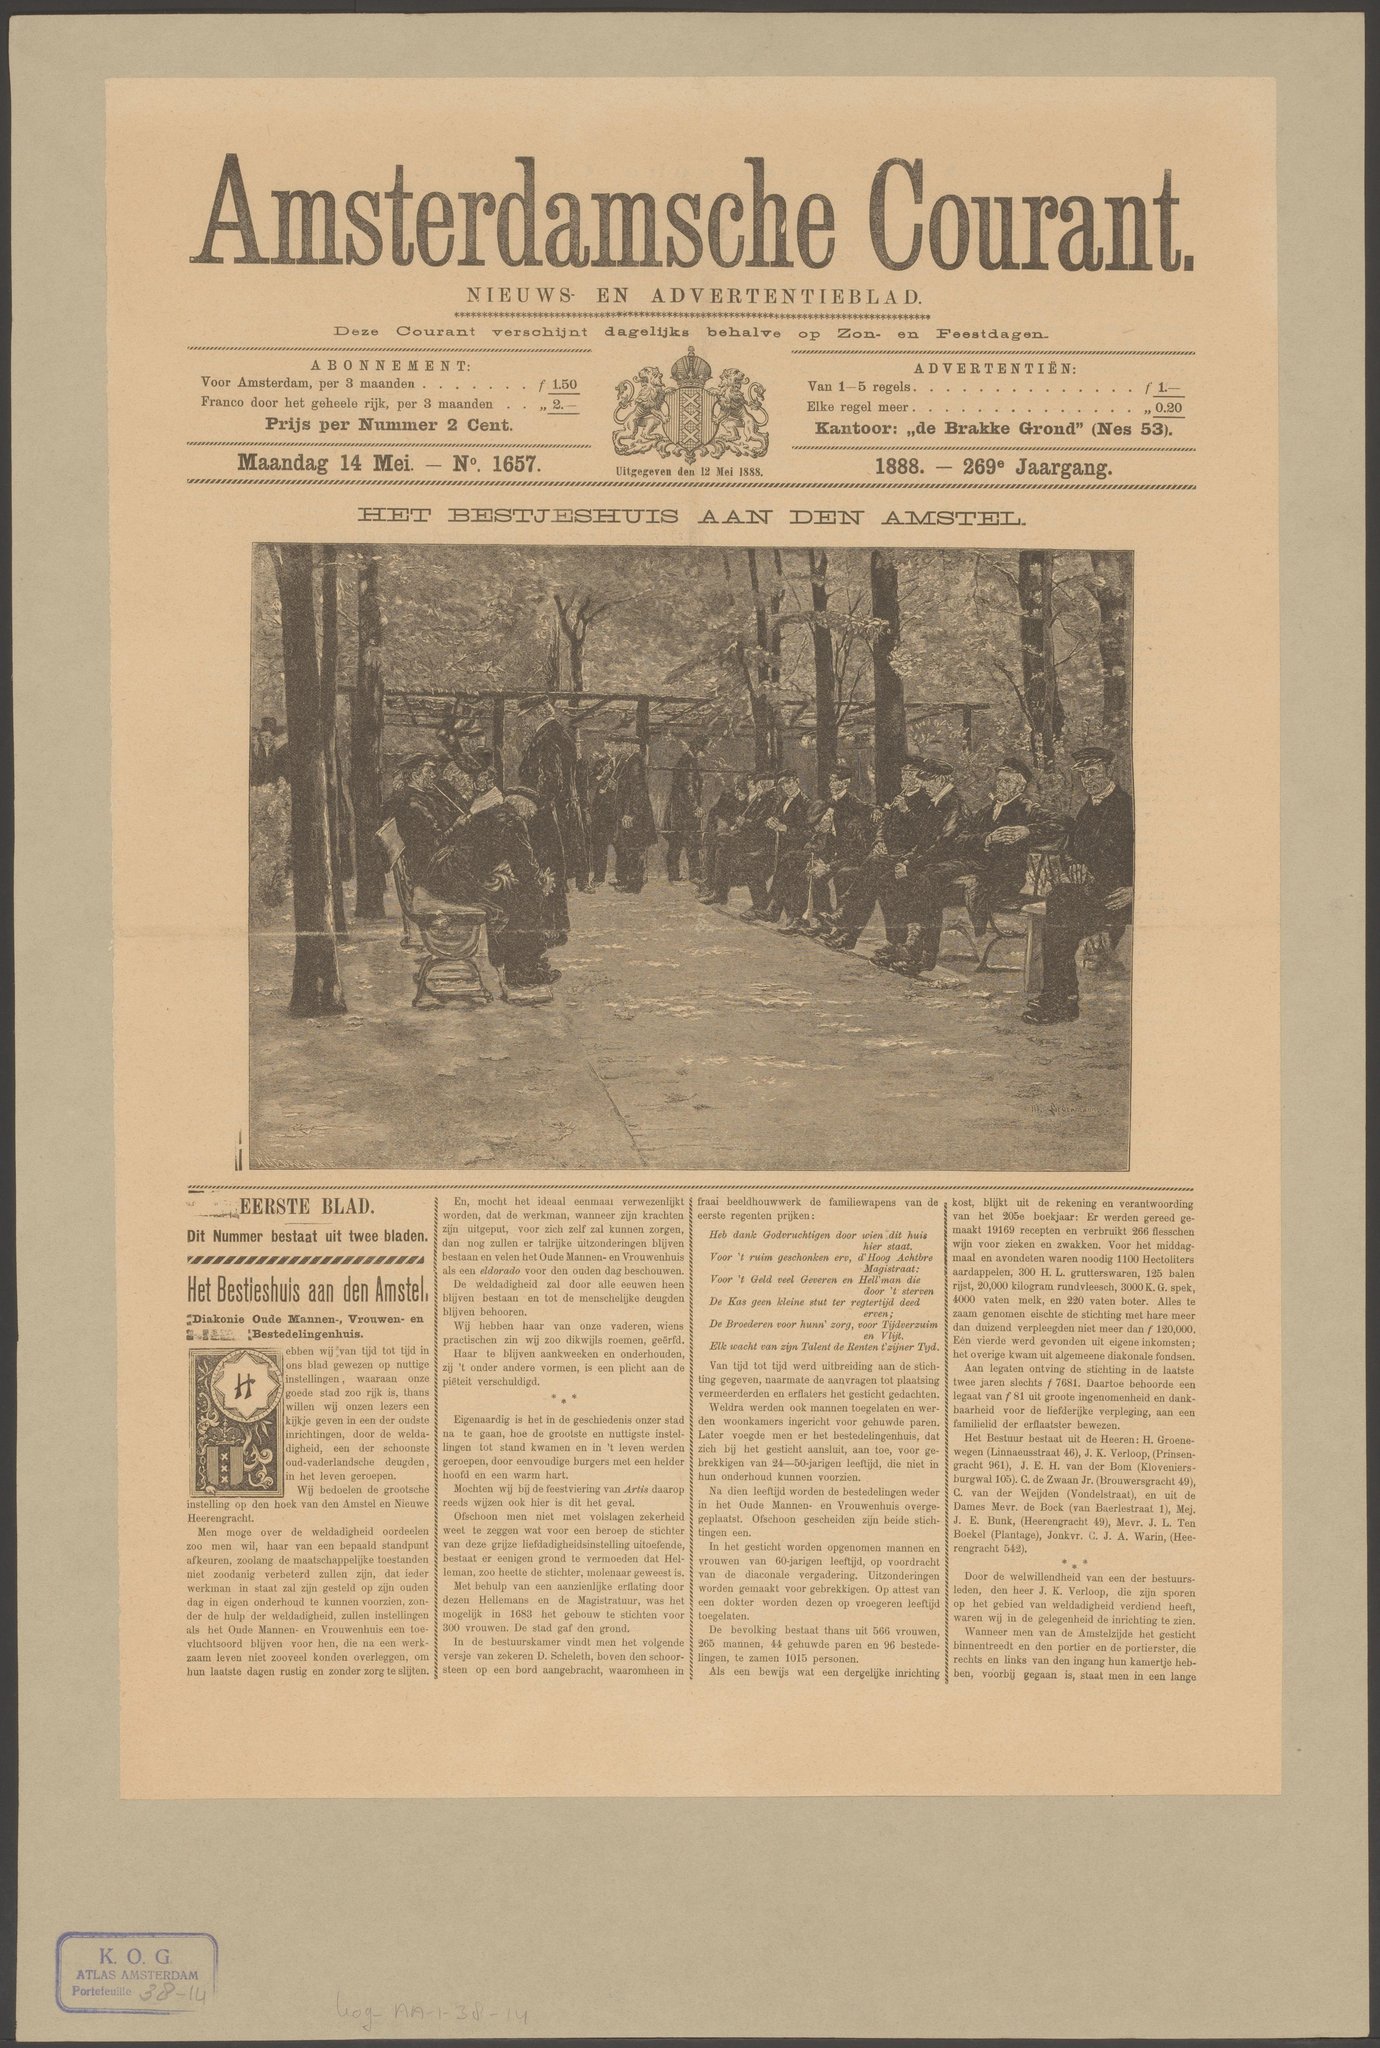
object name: print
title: Oude mannen in de binnentuin van het Diaconie Oude Vrouwen- en Mannenhuis te Amsterdam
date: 1888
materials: paper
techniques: letterpress printing, engraving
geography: amsterdam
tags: old man, courtyard, old-people's home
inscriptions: collector's mark: Lugt 1641b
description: Onderwerpsrubriek binnen de Atlas Amsterdam: Armwezen en liefdadige instellingen: II. Kerkelijke inrichtingen: Diaconie Oude Mannen- en Vrouwenhuis der Ned. Herv. Gem.